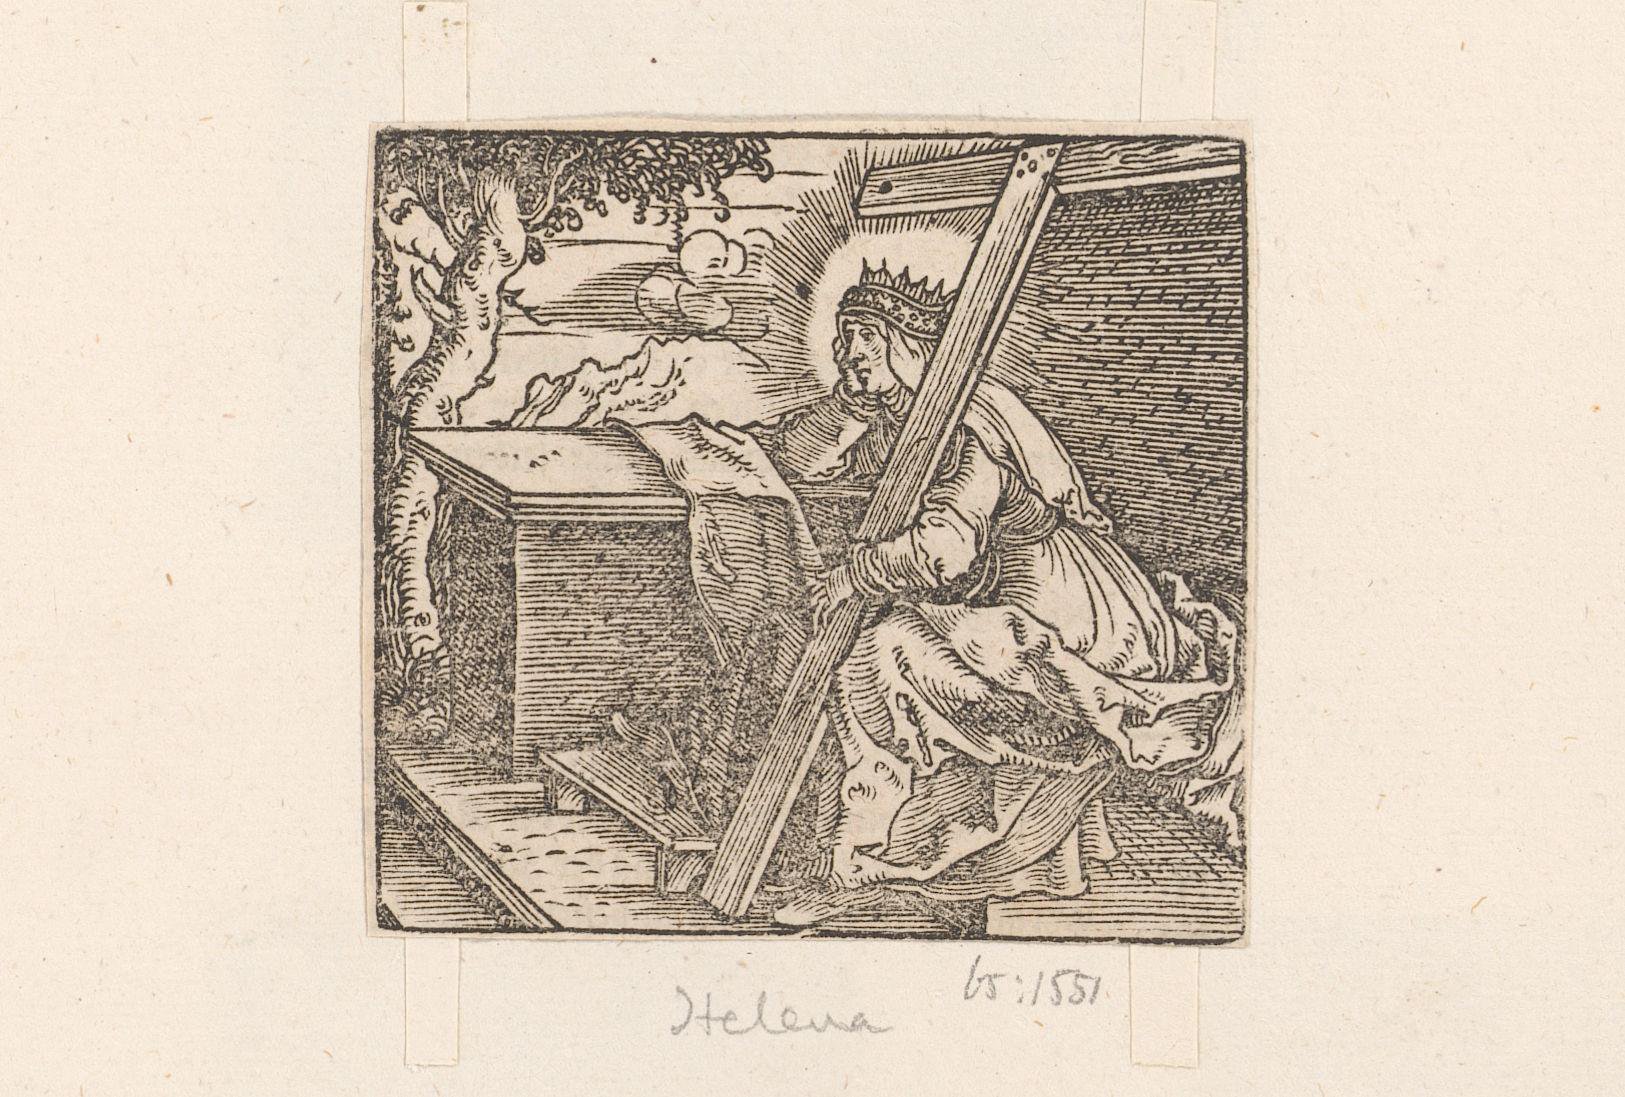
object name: print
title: H. Helena met het kruis in haar arm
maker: Anonymous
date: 1500-1536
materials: paper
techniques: woodcut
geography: germany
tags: empress helena, mother of constantine the great; possible attributes: model of church, (royal) crown, crown of thorns, cross, three nails - personal devotion of female saint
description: De Heilige Helena zit in een landschap bij haar knielbank met het kruis in haar armen. Prent maakt deel uit van een album.